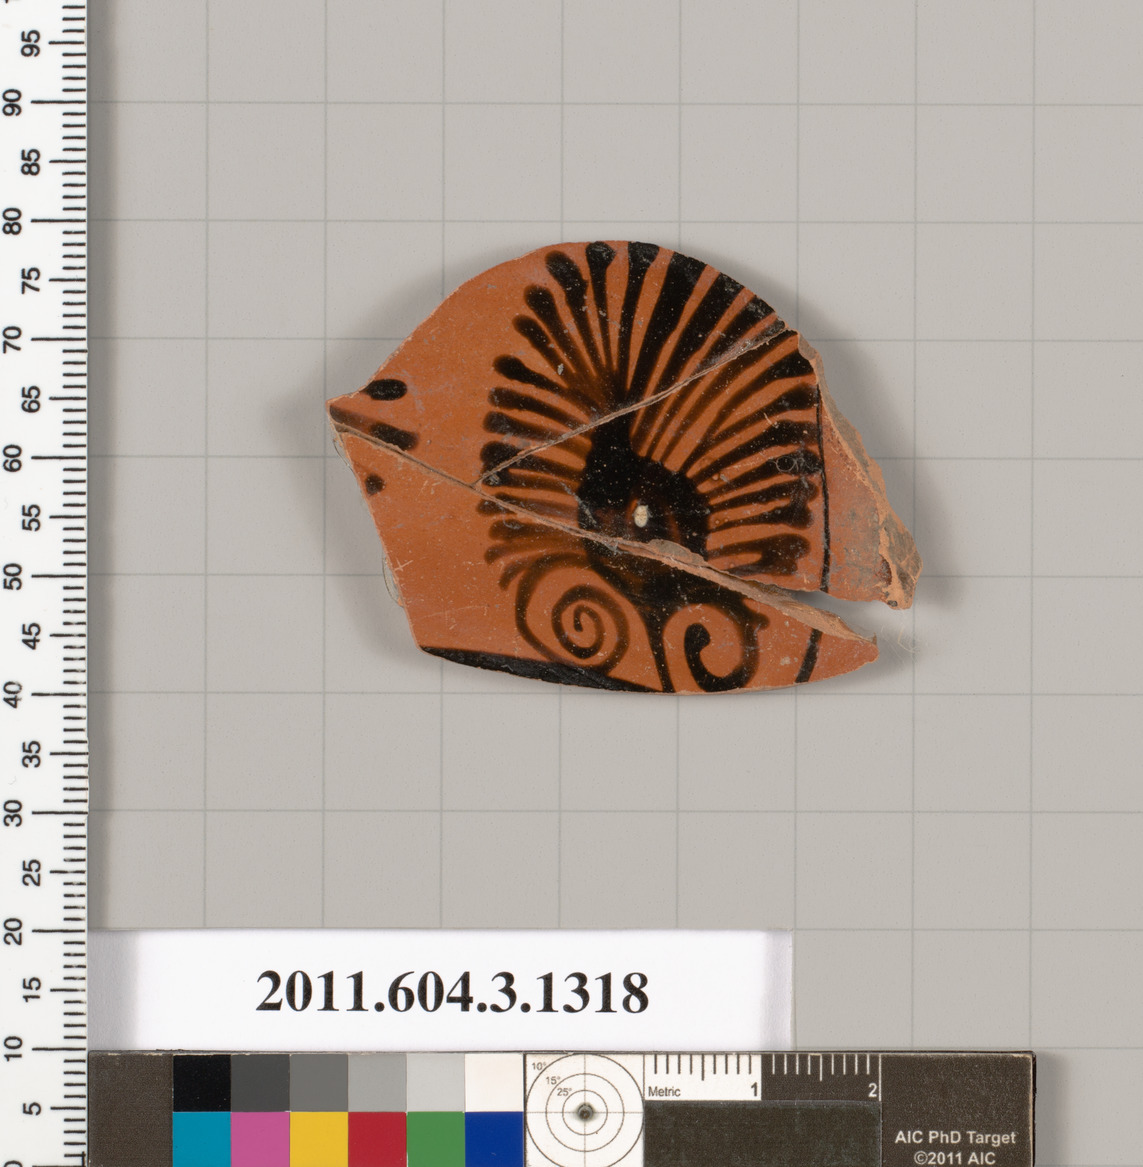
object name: skyphos fragment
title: Terracotta fragment of a skyphos (deep drinking cup)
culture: greek, attic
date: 490-480 BCE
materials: terracotta